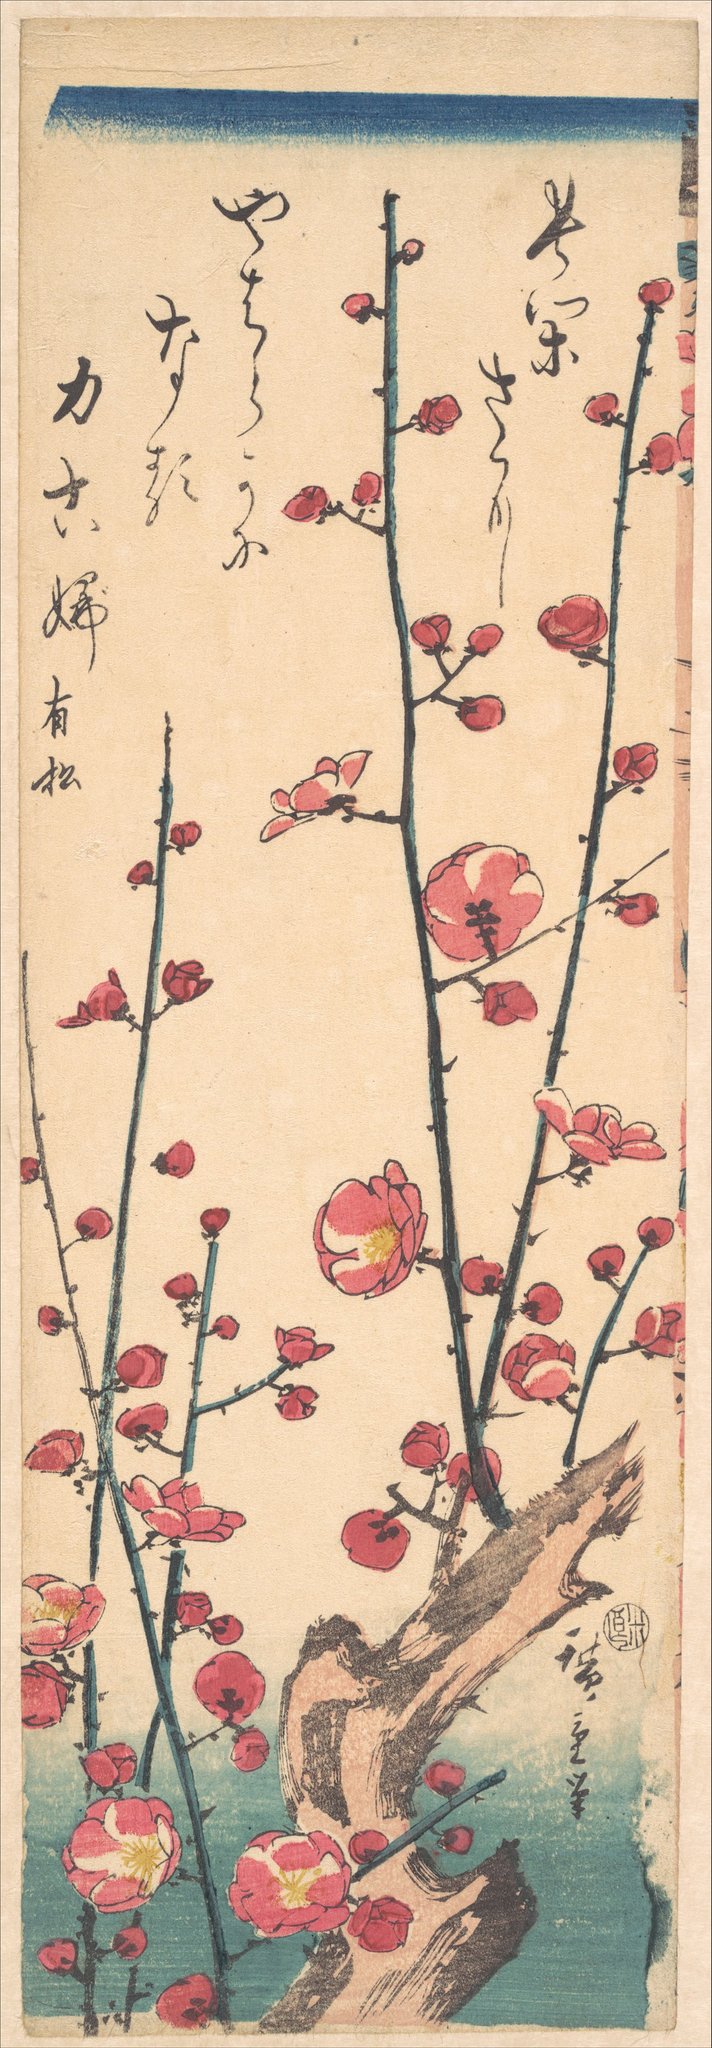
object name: print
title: Flowering Plum Tree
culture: japanese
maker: utagawa hiroshige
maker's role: artist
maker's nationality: japanese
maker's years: 1797-1858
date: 1843-1847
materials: ink, paper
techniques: nishiki e, woodblock print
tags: flowers,plants